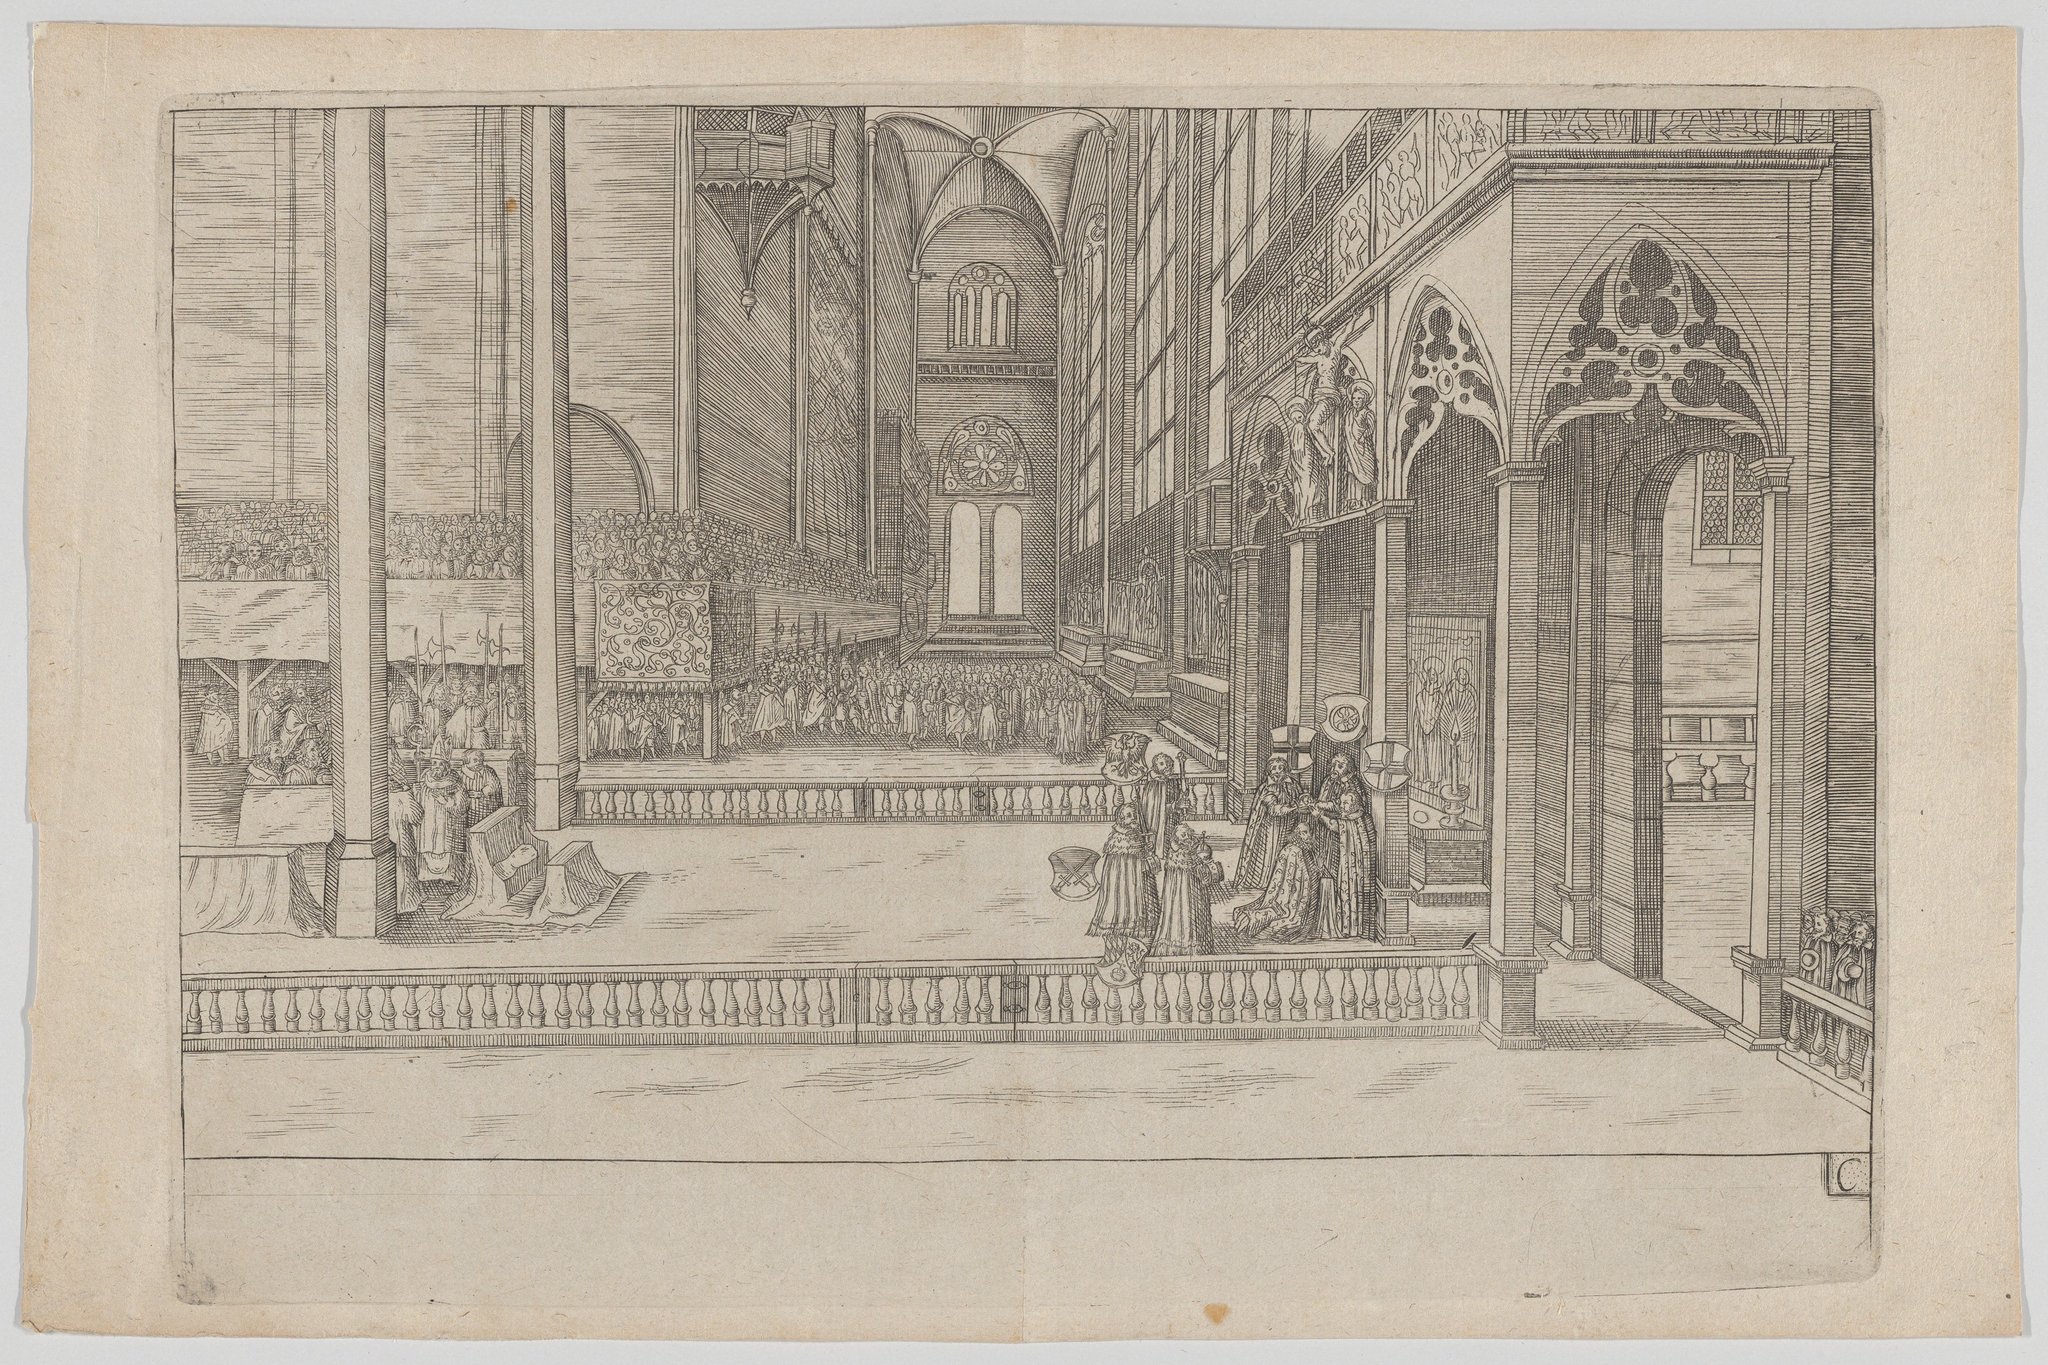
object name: print, fete, ornament architecture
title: Plate C: Election and Coronation of Emperor Maximilian II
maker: anonymous, german, 17th century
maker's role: publisher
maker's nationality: german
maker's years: 1600-1700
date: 1612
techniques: etching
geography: frankfurt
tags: elections,men,women,crowd